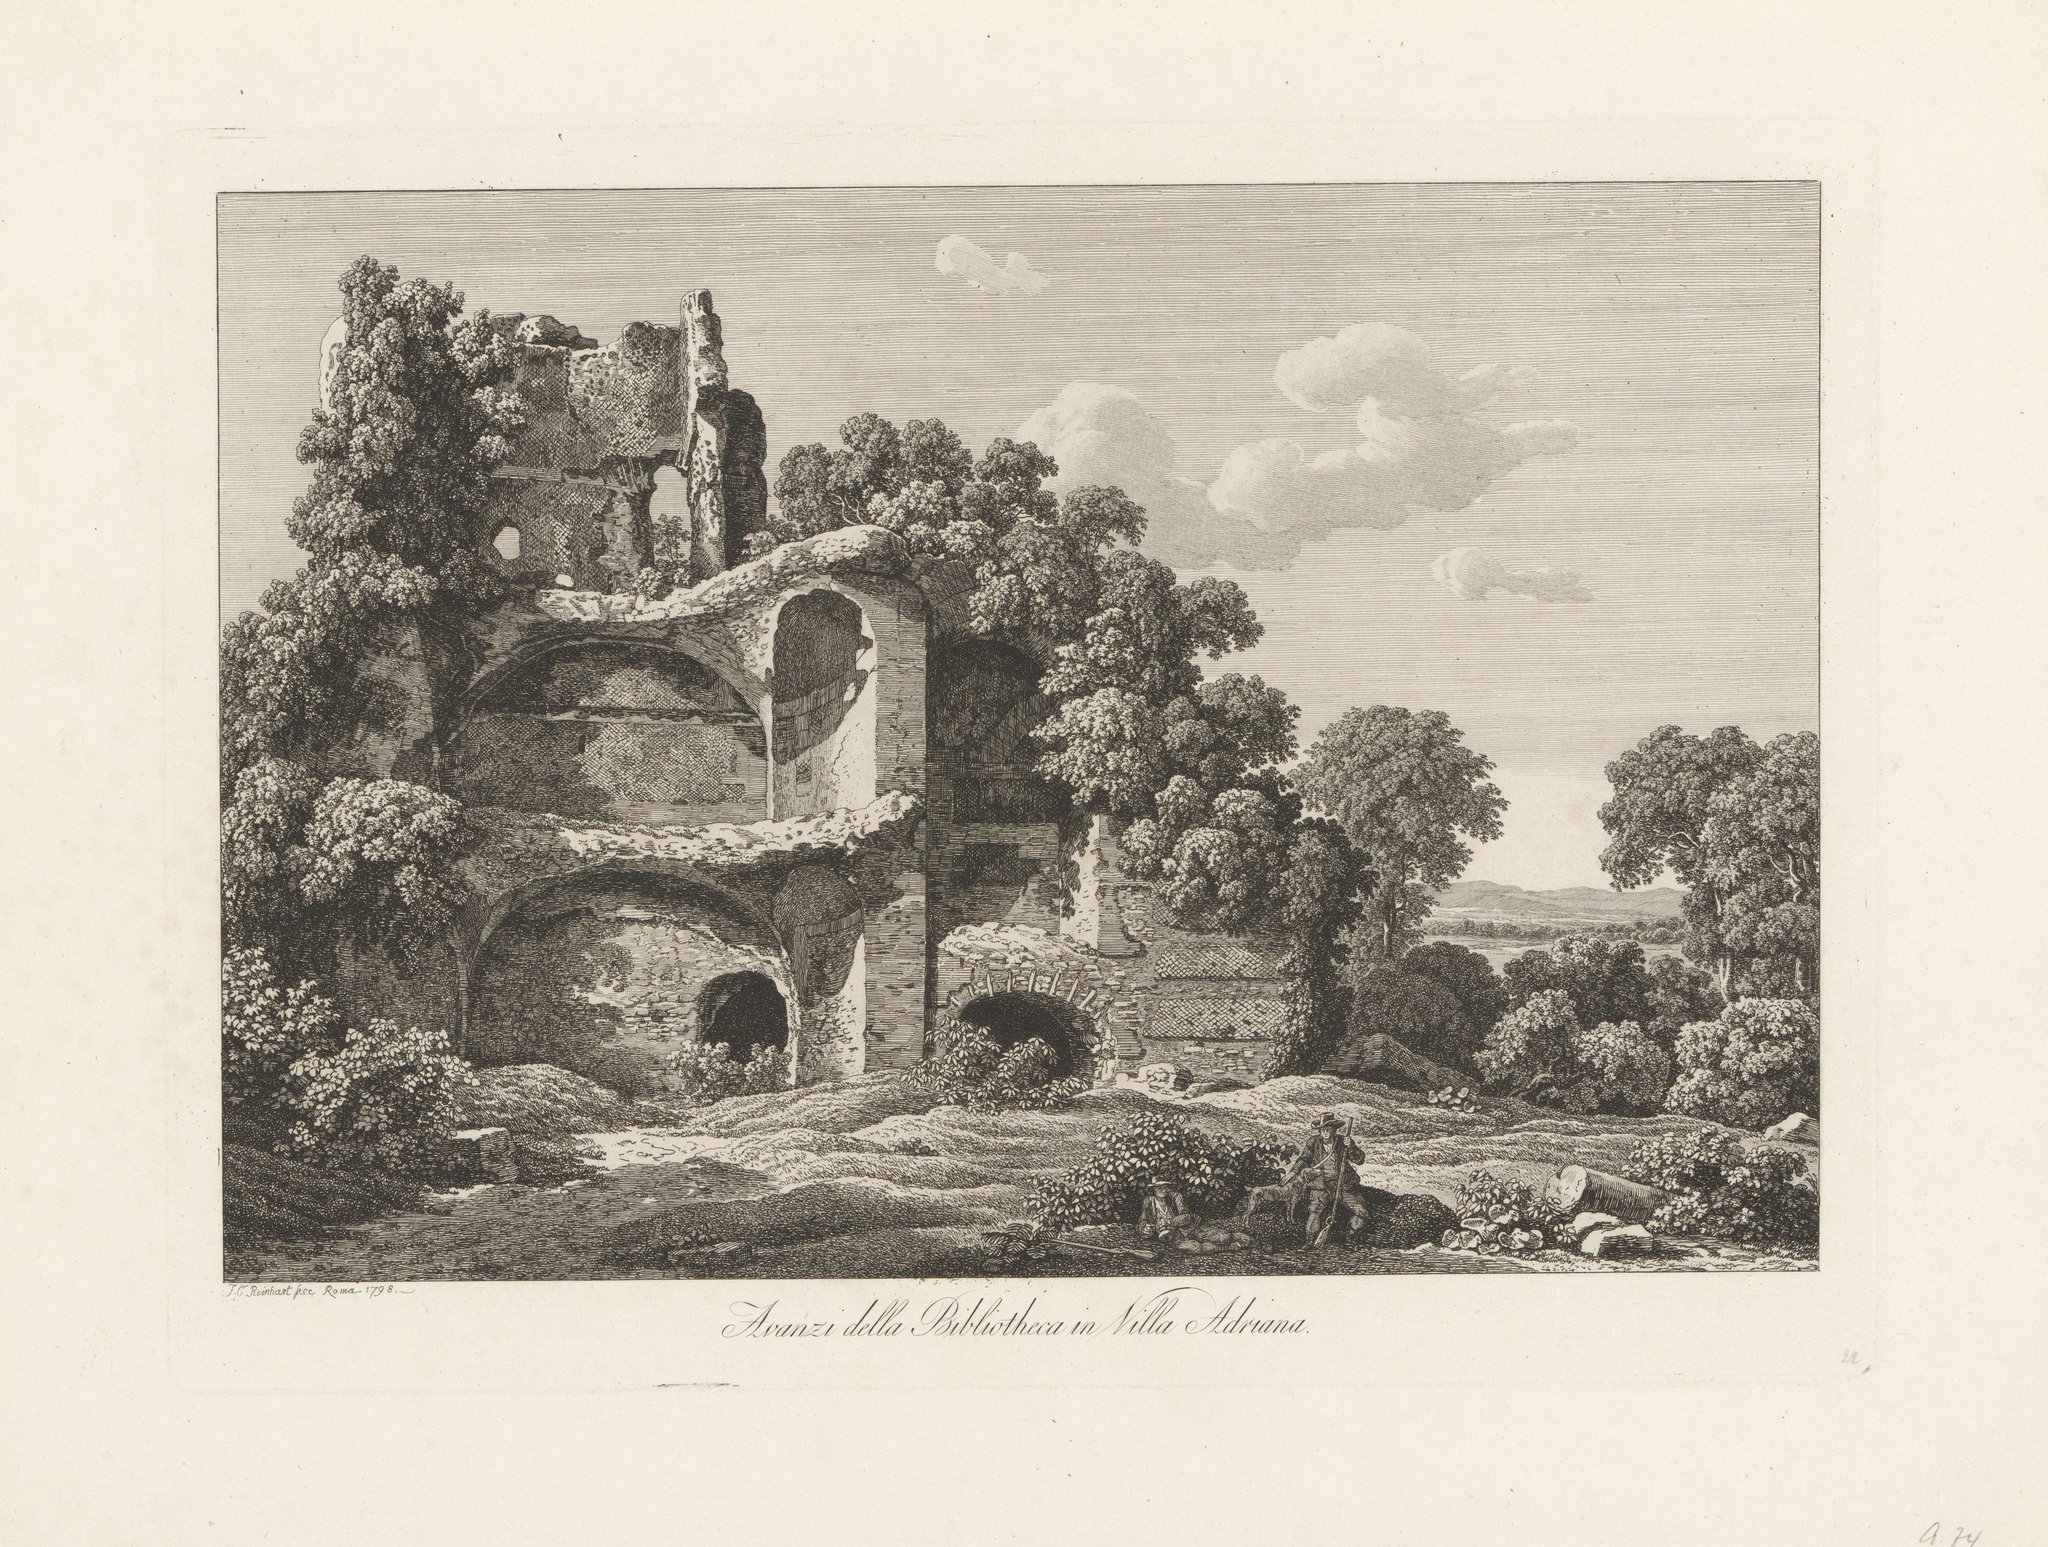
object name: print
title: De ruïne van Villa Driana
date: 1798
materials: paper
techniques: engraving, etching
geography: nuremberg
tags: landscapes, landscape with monument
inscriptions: collector's mark: Lugt 2228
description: Behorend tot een serie van 72 'Mahlerisch-radirte Prospecte von Italien', waarvoor de kunstenaar 24 prenten maakte. Albert Christoph Dies (1755-1822) en Jacob Wilhelm Mechau (1745-1808) maakten eveneens 24 platen, in opdracht van Jean Fréderic Frauenholz. Vanaf 1792 verschenen telkens drie sets van twee prenten per kunstenaar. In 1798 werd de laatste set uitgegeven, waarna complete sets gebonden werden uitgegeven tot in 1875 (Nuerenberg: J.L. Lotzbeck). Zie: Schmid, F.C., A.C. Dies, J.W. Mechau und J.C. Reinhart 'Mahlerische radirte Prospecte von Italien' (...). Berlijn: s.n., 1991.